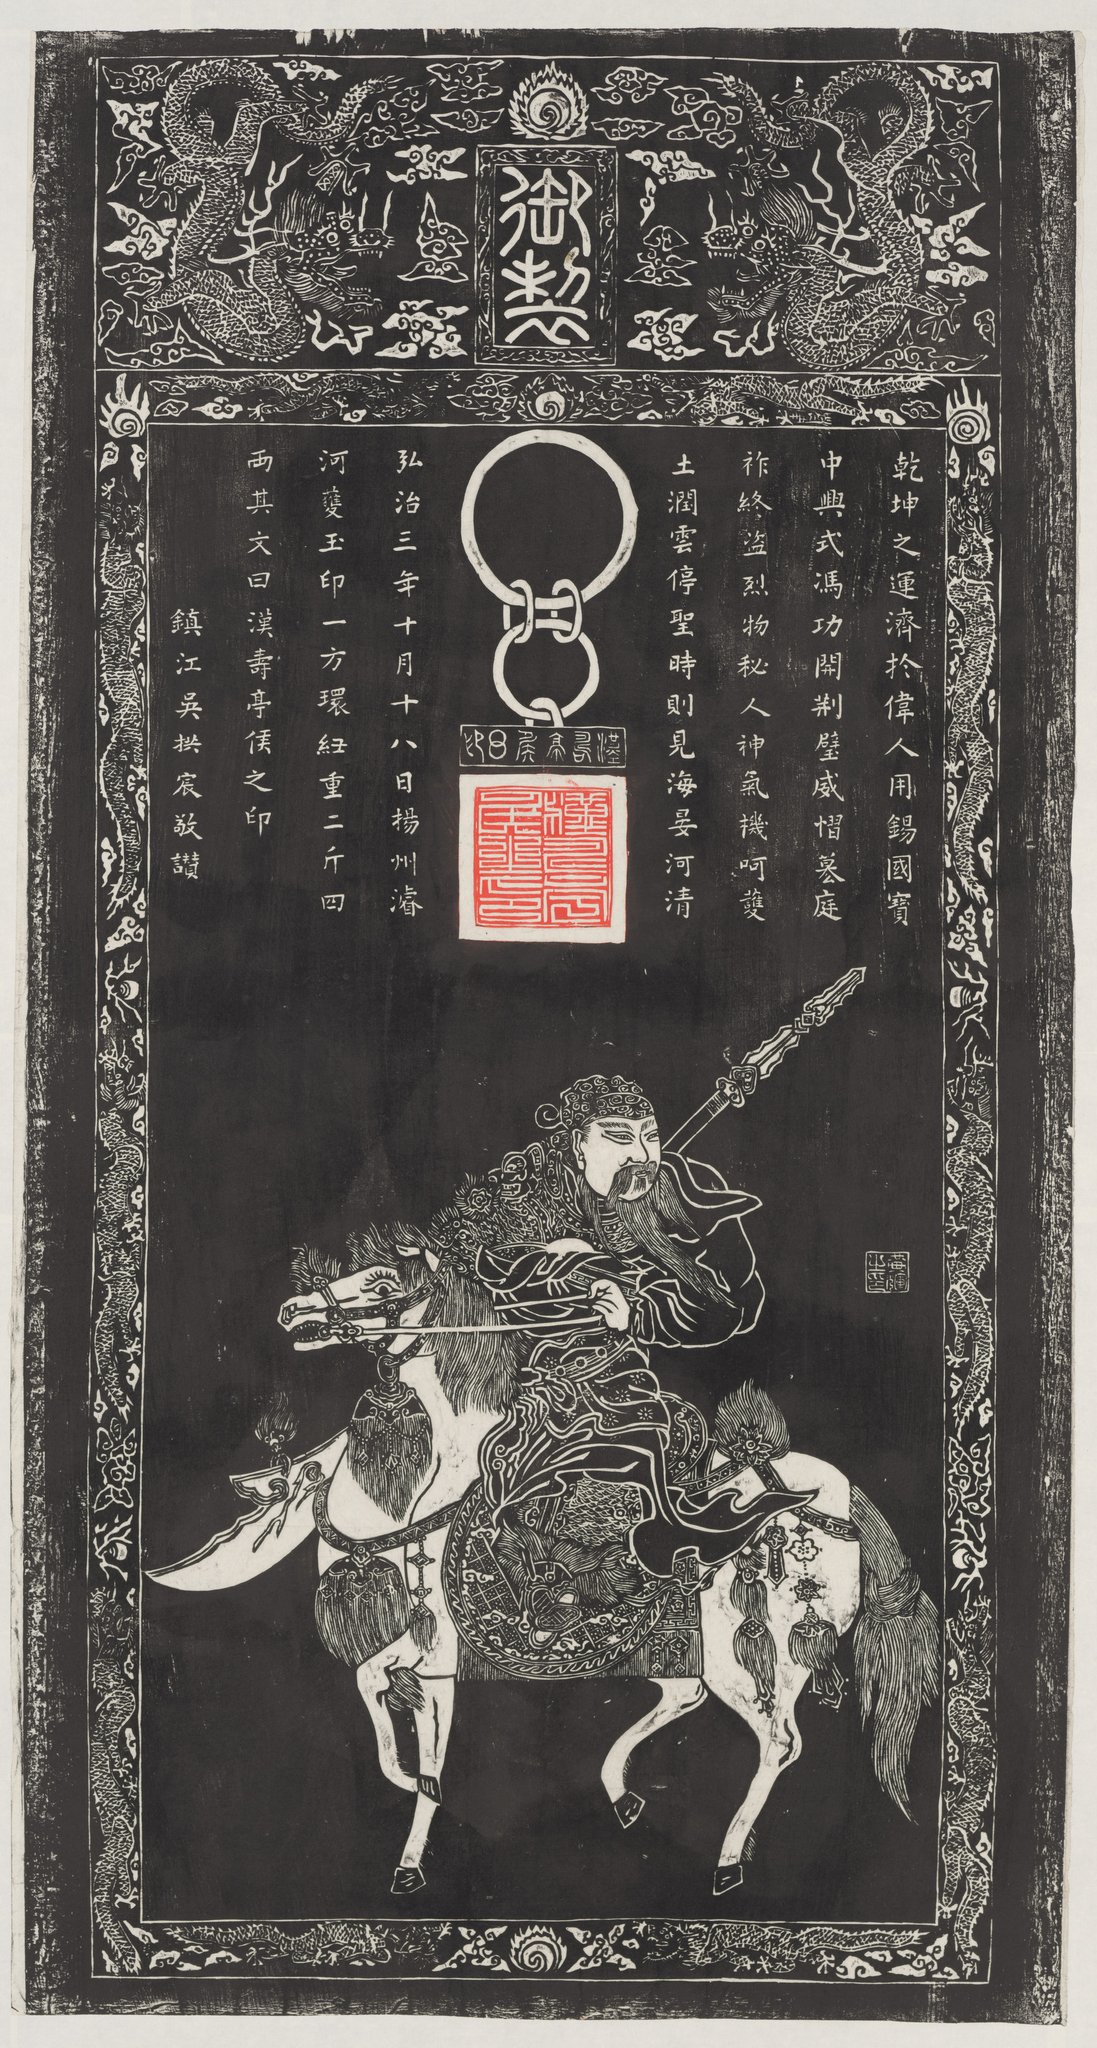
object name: rubbing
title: Rubbing of Guandi (War God) from a Ming dynasty stone carving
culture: chinese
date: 1901-2000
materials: ink, paper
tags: men,horses